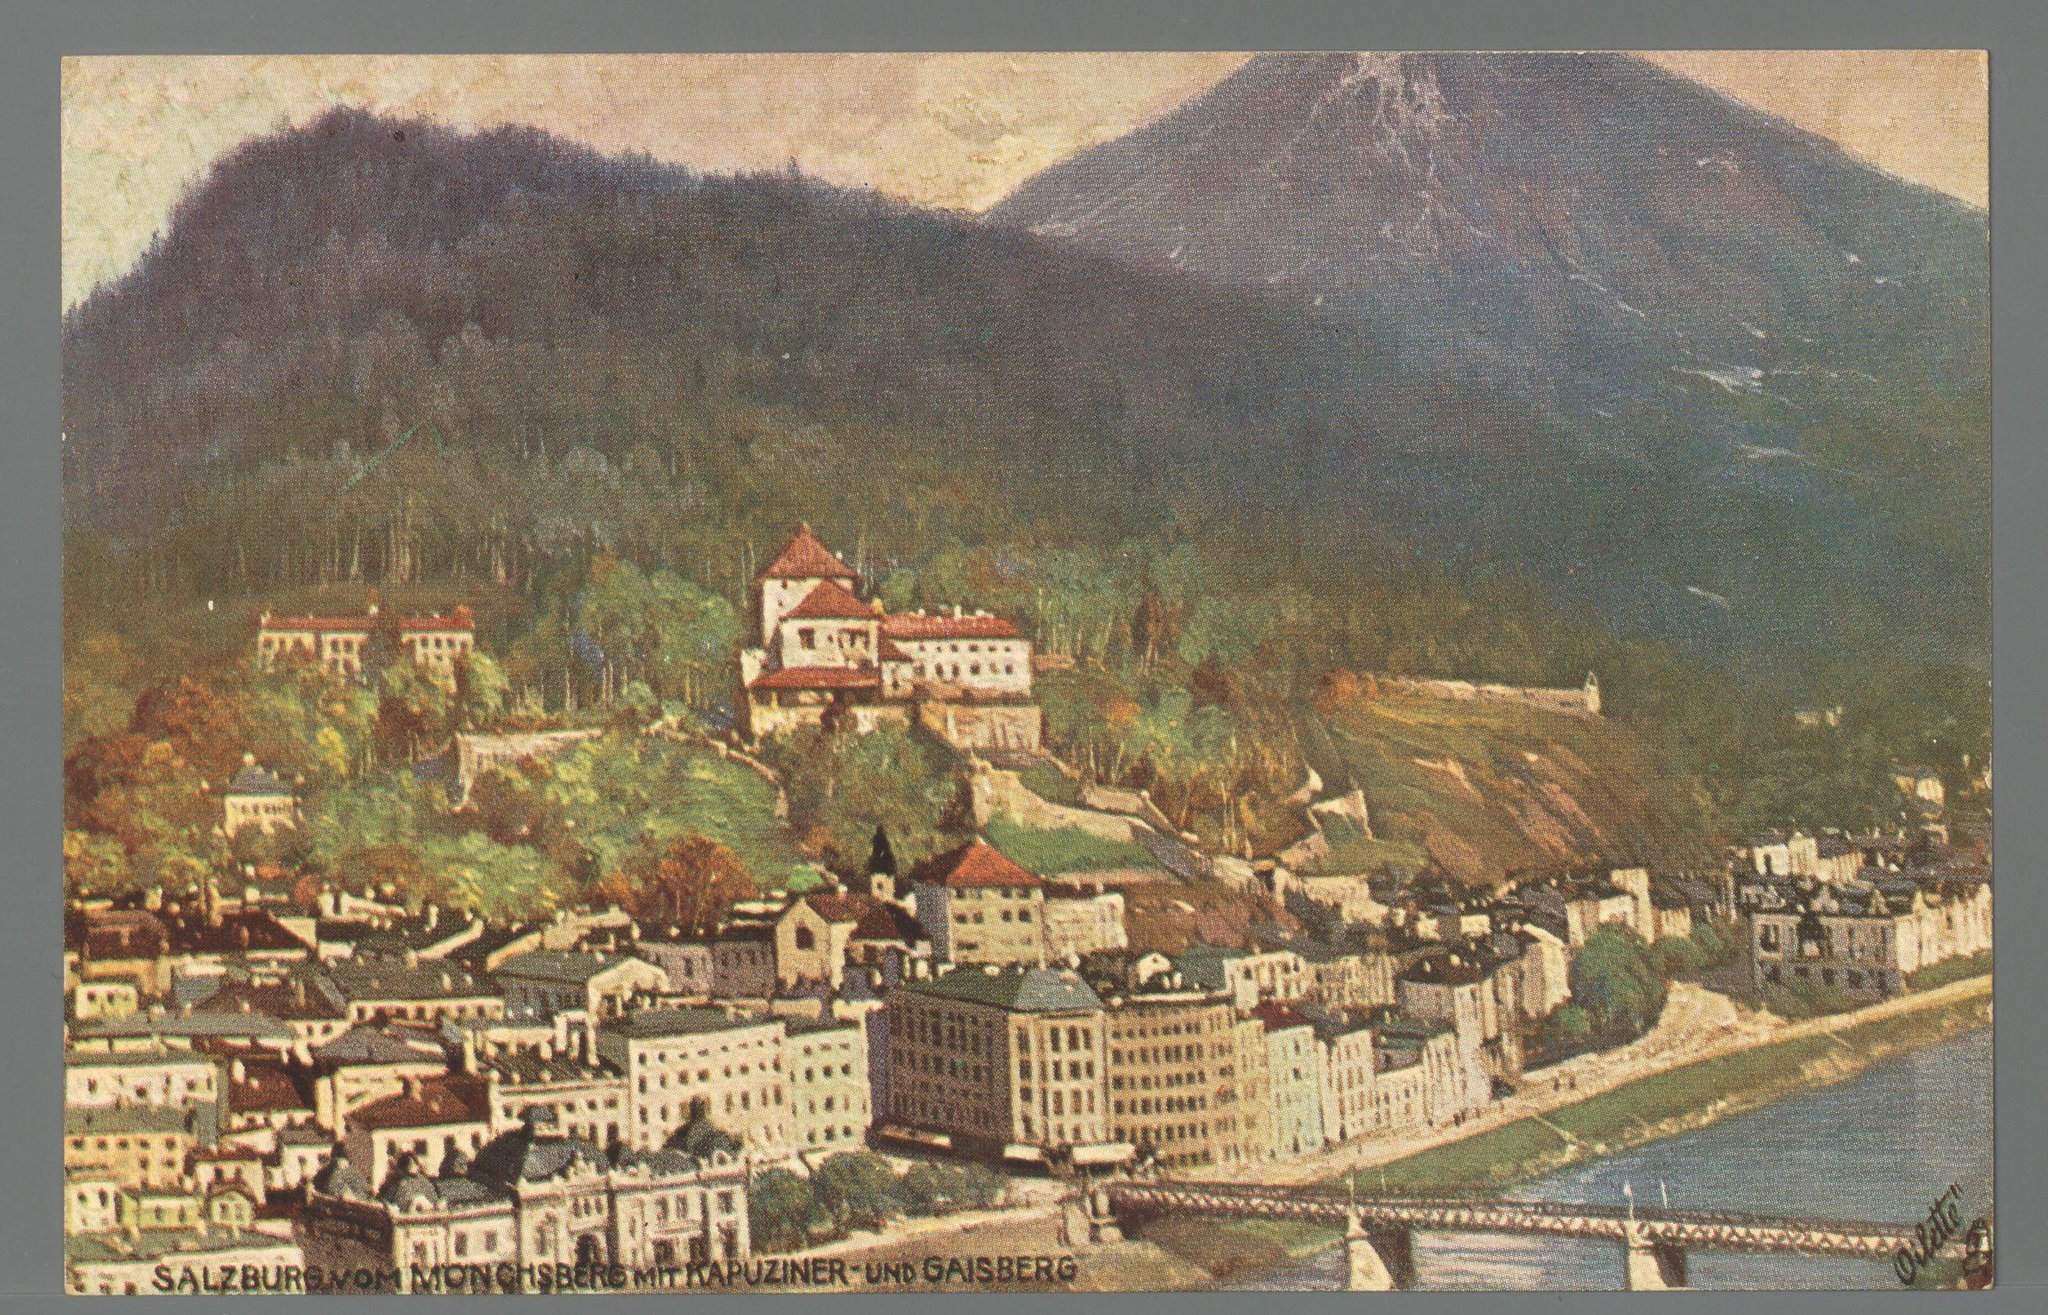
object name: reproduction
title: Weite-Weite-Welt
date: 1904-1909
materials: cardboard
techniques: writing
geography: salzburg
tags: city-view, and landscape with man-made constructions, canals, waters (in city), mountains